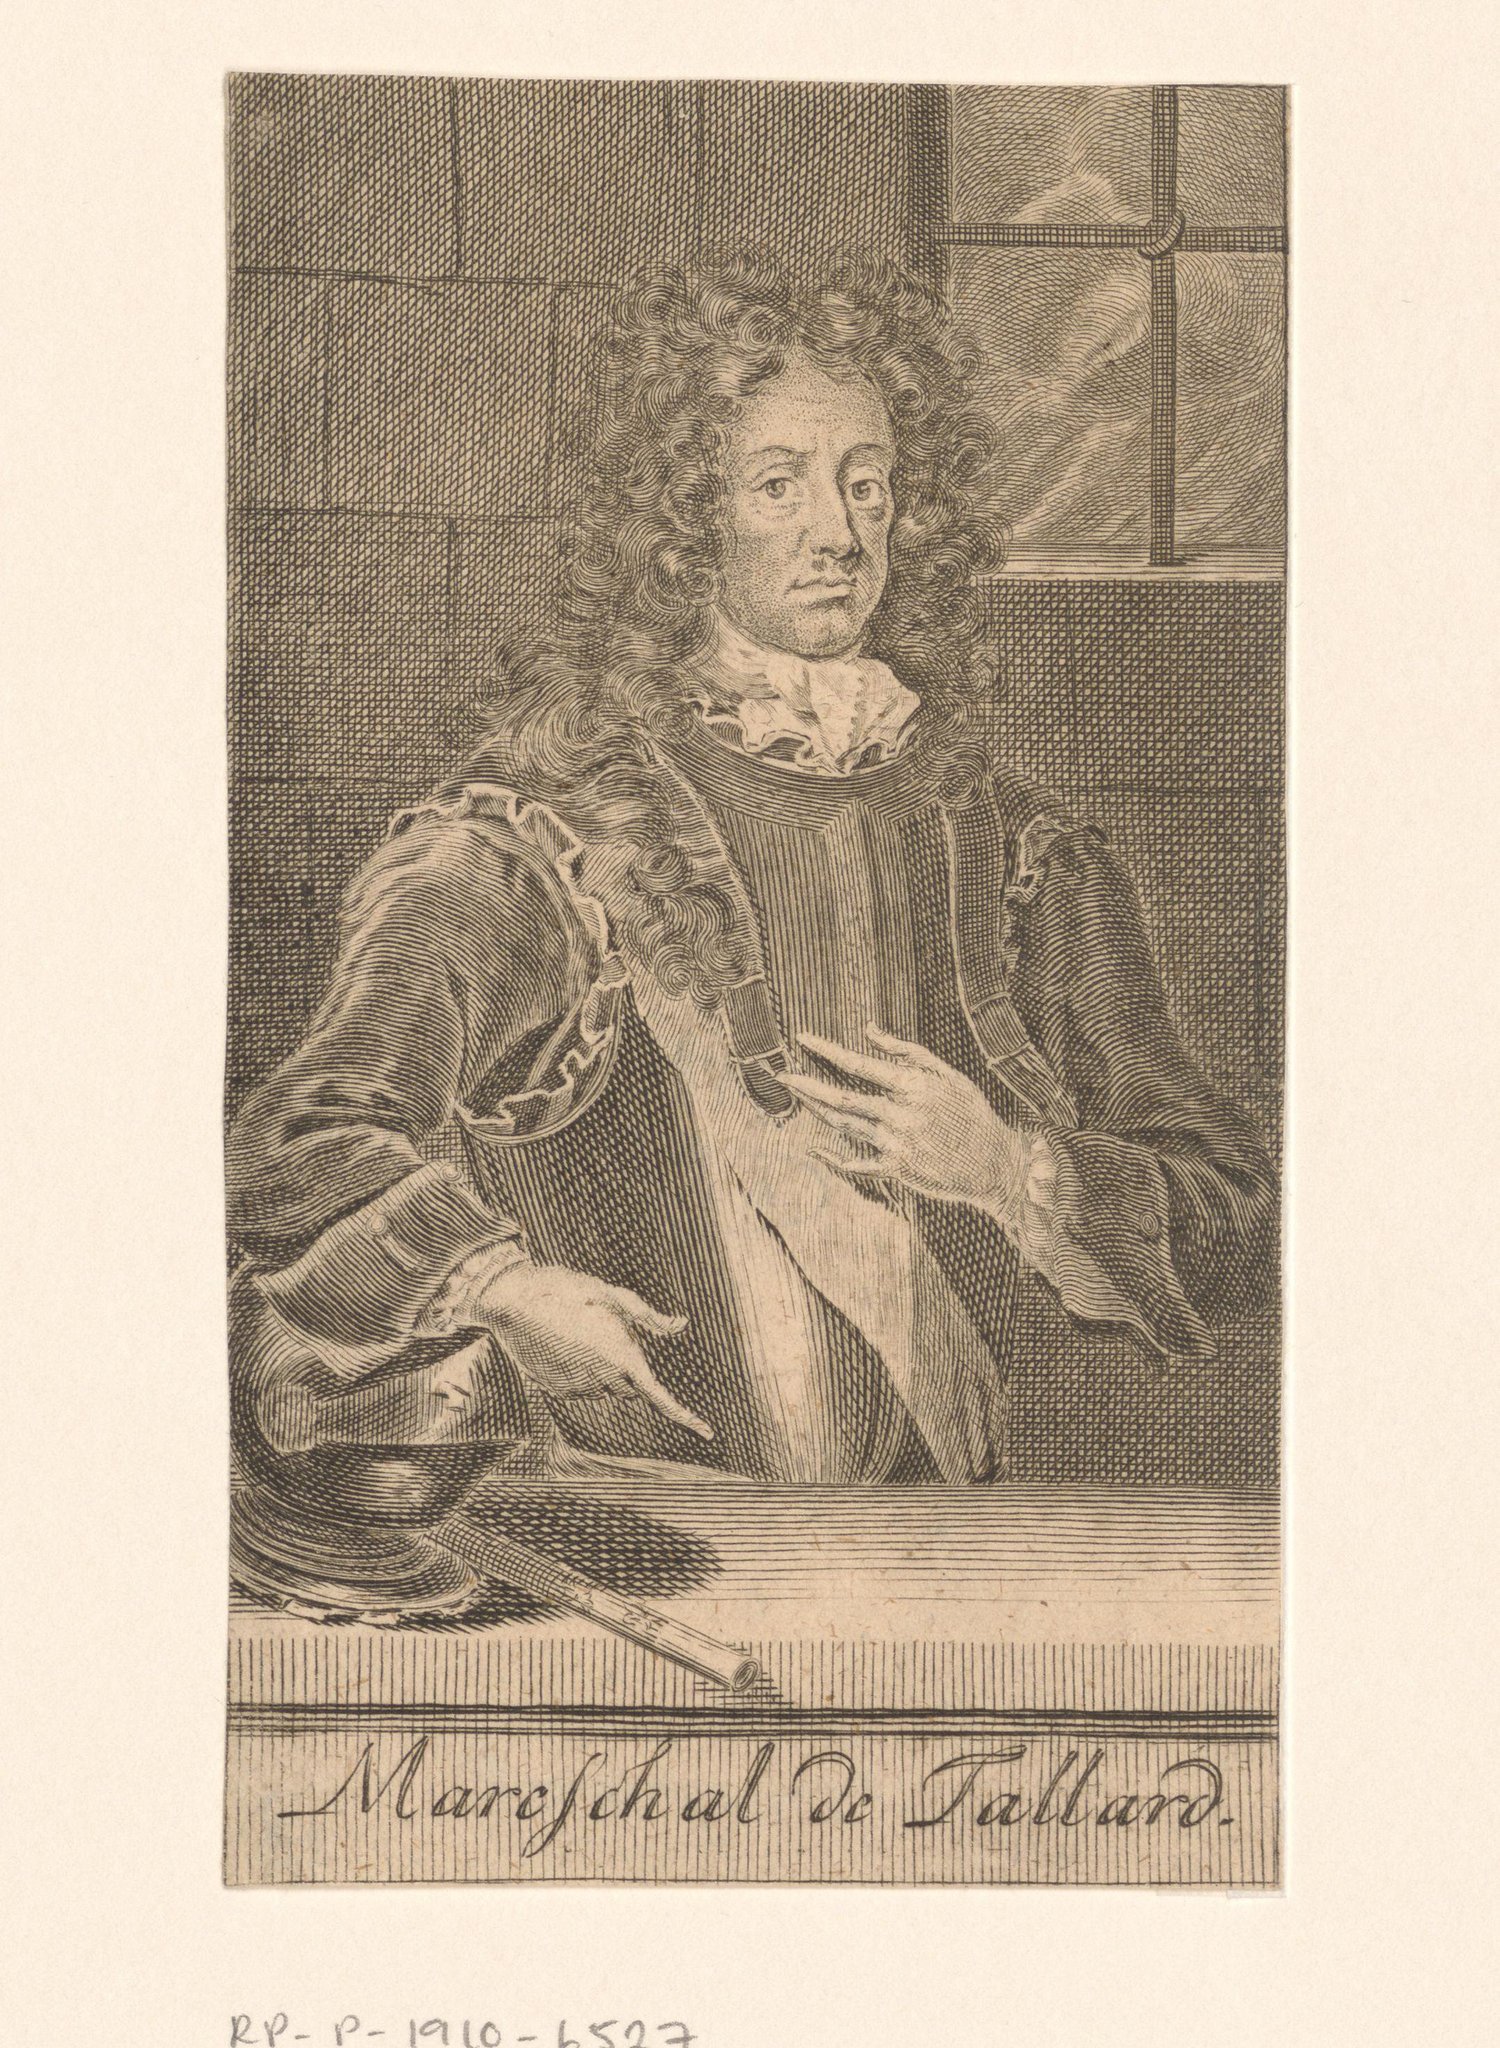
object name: print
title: Portret van Camille d'Hostun, hertog van Tallard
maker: martin bernigeroth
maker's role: print maker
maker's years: 1670-1733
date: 1704-1723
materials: paper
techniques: engraving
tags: helmet, commander-in-chief, general, marshal, historical persons, baton of general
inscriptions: collector's mark: Lugt 2228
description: Prent gebruikt in: Die Europäische Fama, Welche den gegenwärtigen Zustand der vornehmsten Höfe entdecket. S.l.s.n., 1704, dl. 26. Prent ook gebruikt in: Frantzösisches Crönungs-Ceremonial (...). Frankfurt am Main en Leipzig: s.n., 1723.